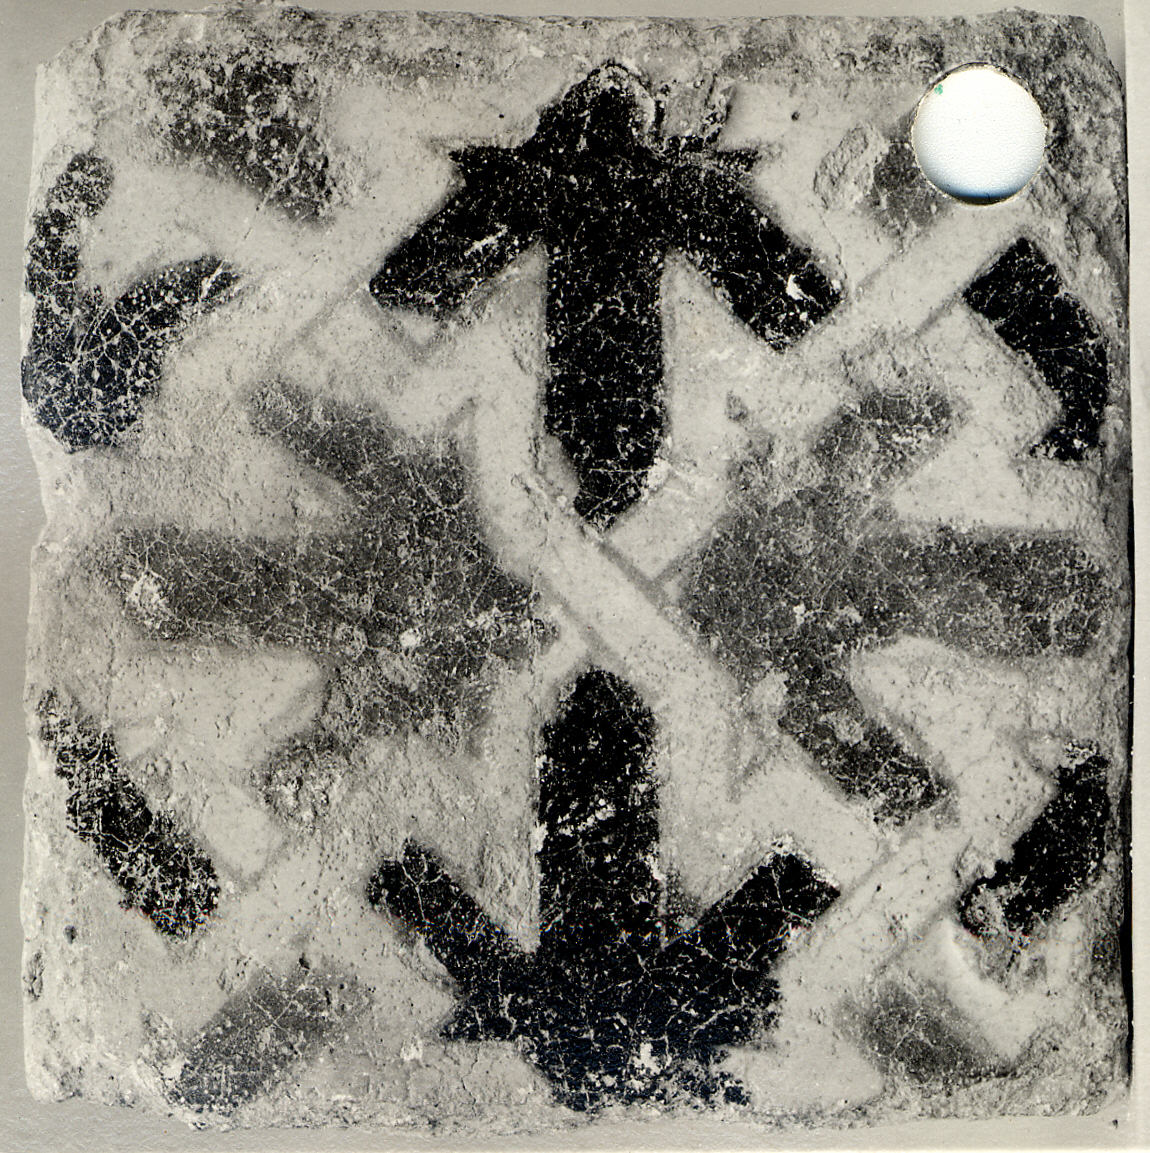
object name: tile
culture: spanish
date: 1401-1500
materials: earthenware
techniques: glazing